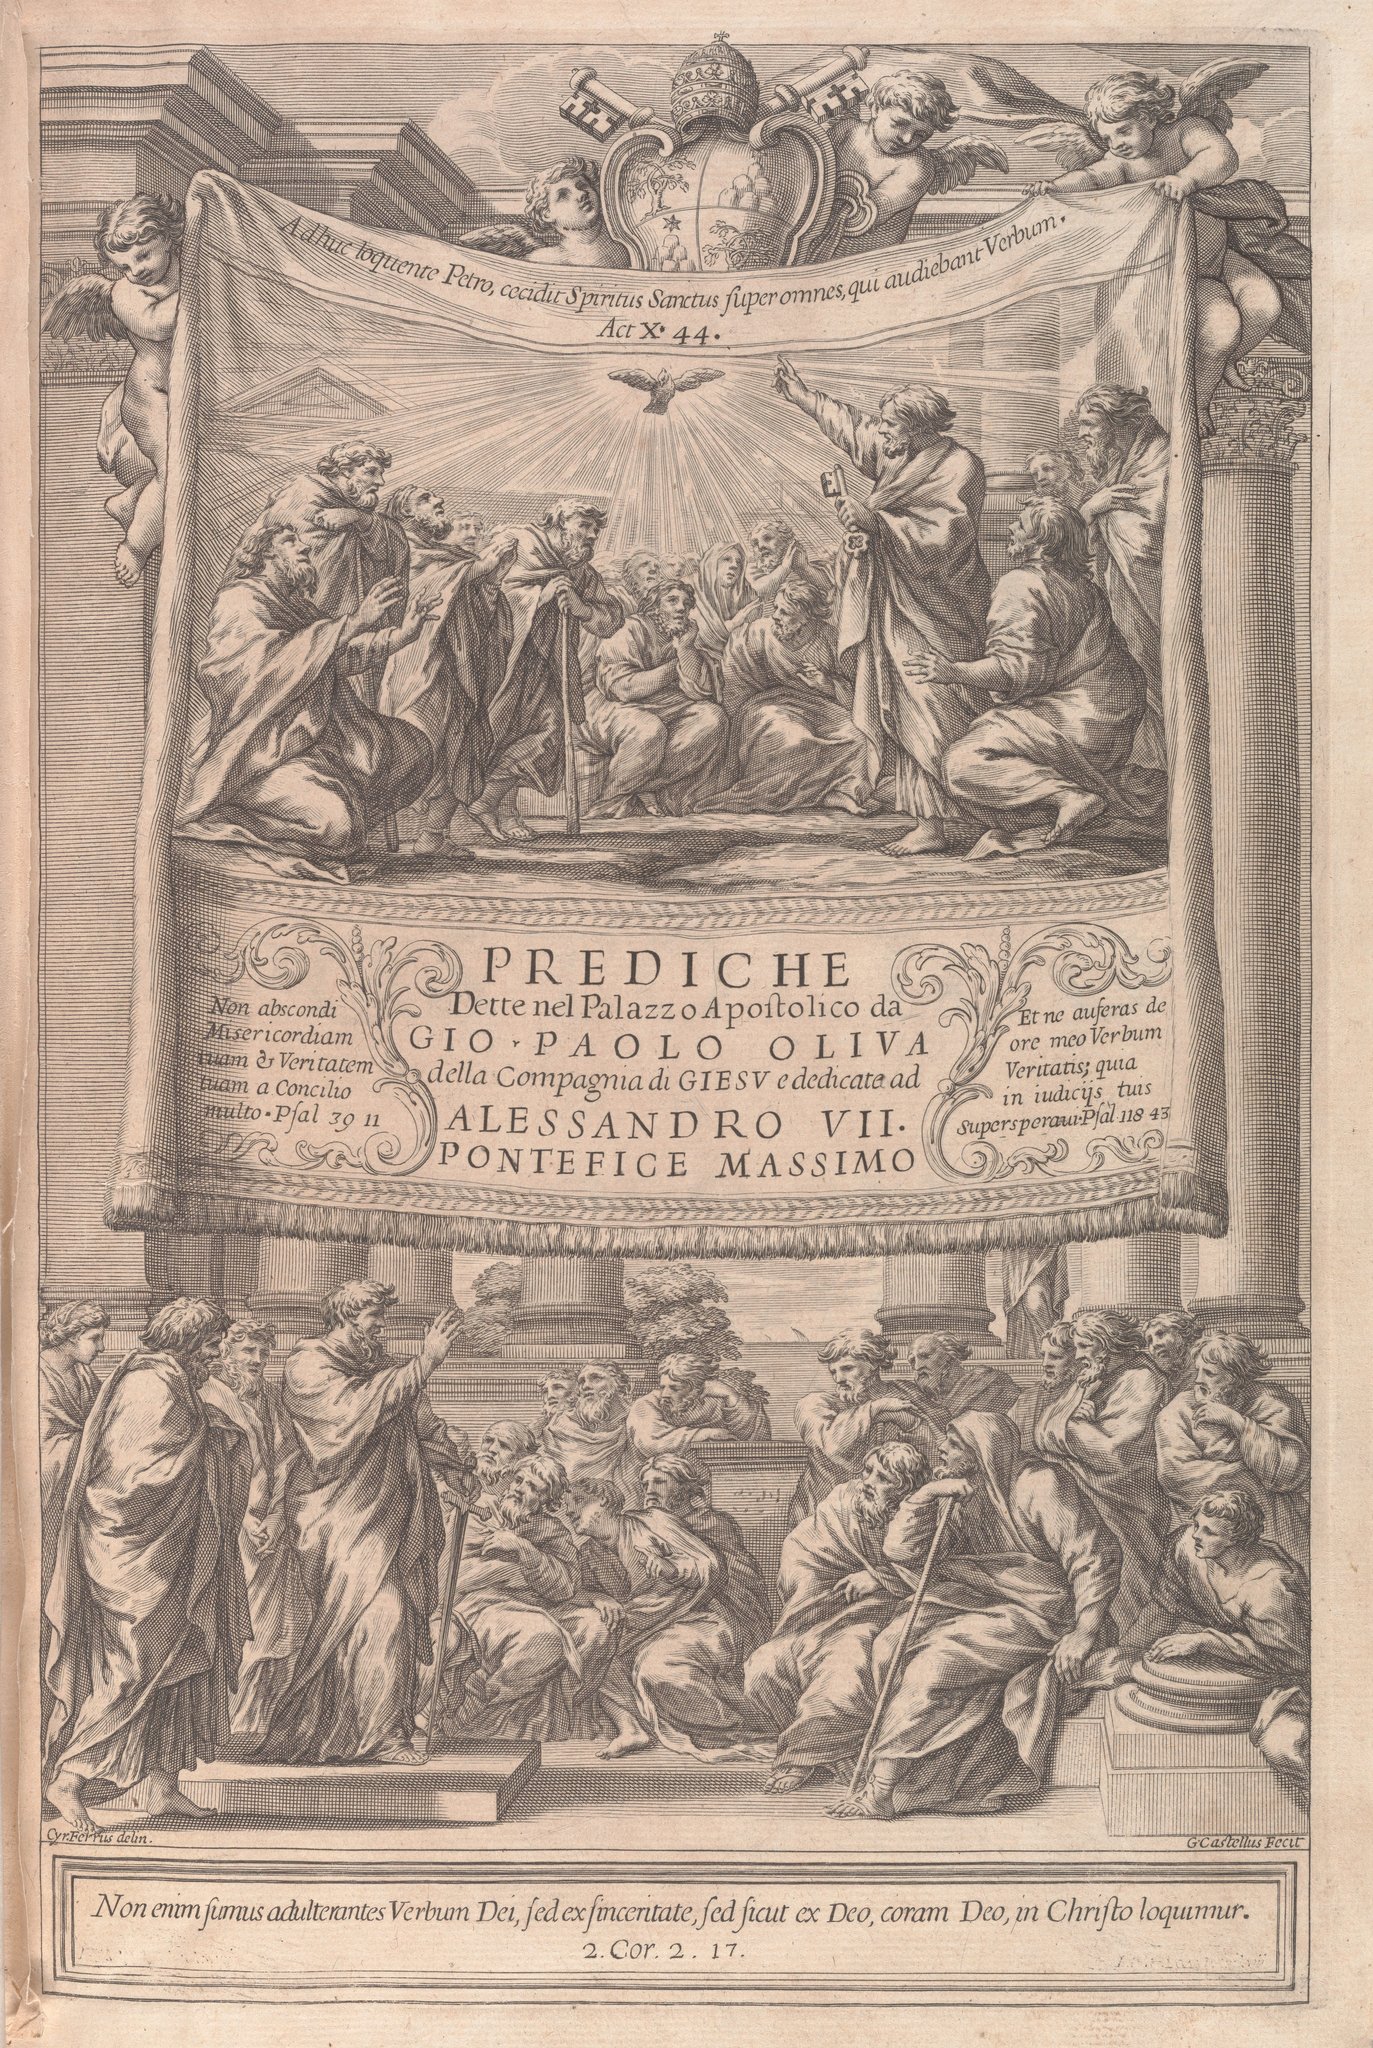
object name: book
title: Prediche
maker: gian paolo oliva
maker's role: author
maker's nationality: italian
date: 1664-1680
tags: eagles,men,cupid,christ